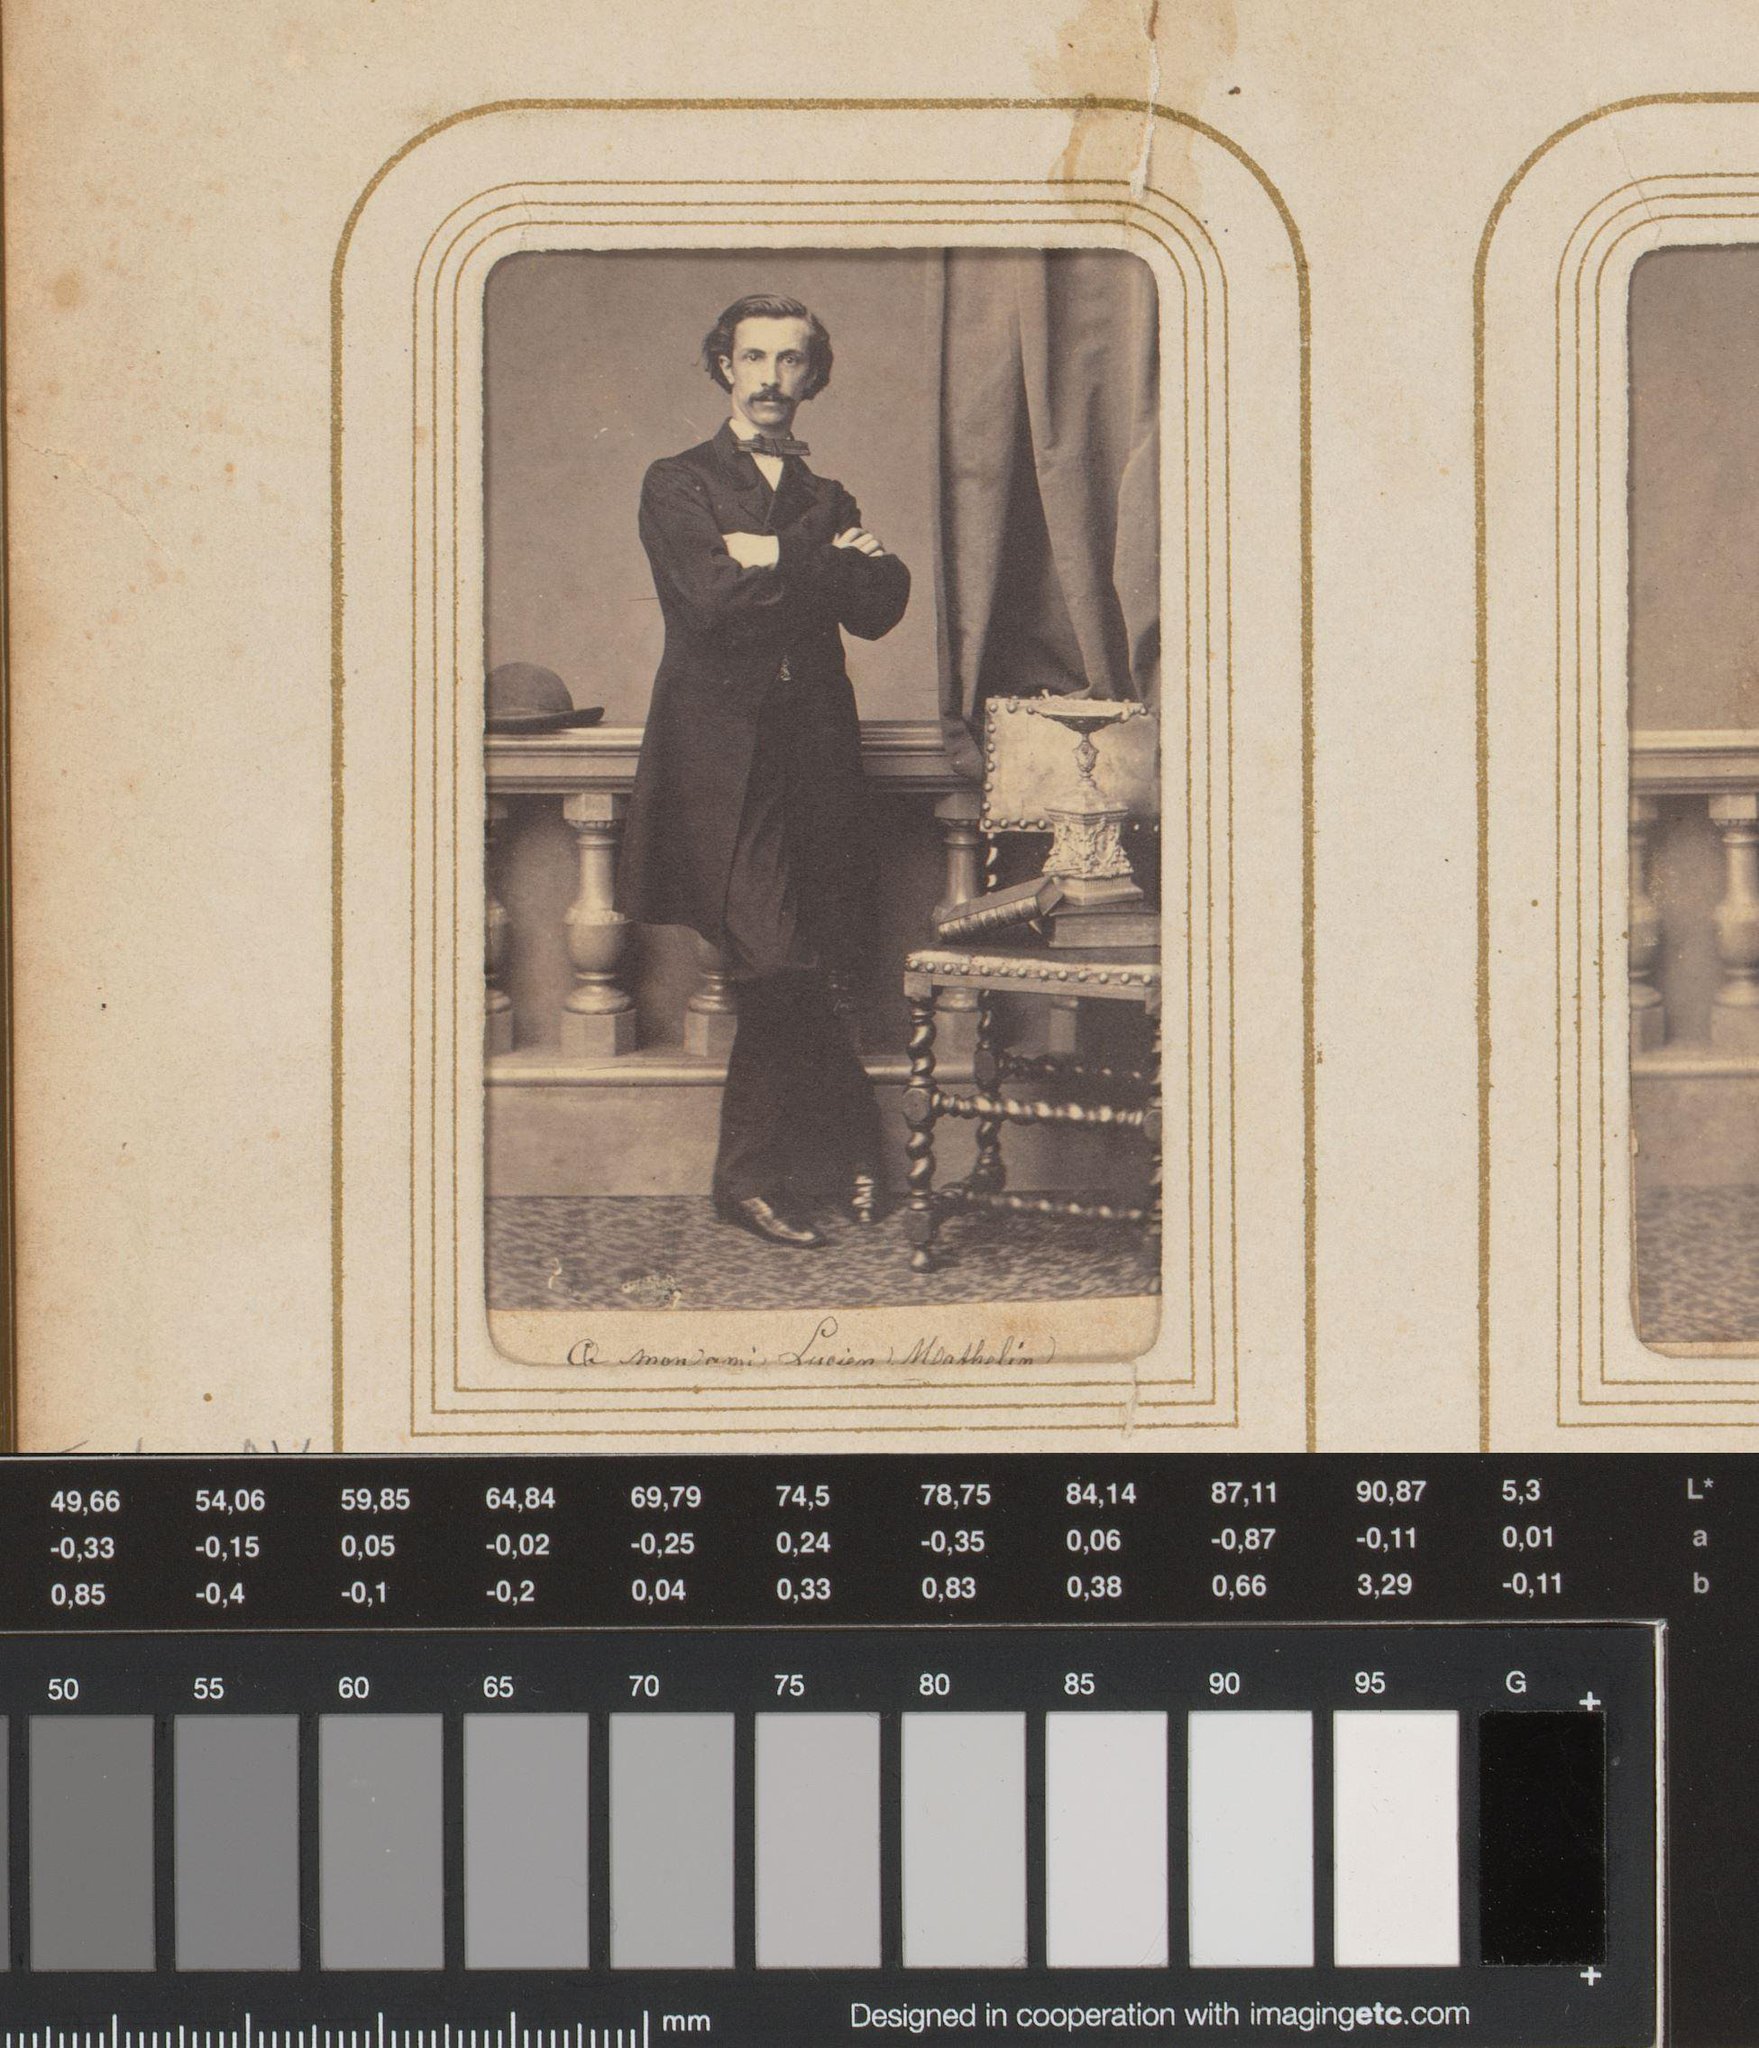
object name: carte de visite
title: Portret van Lambert Herman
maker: Anonymous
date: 1861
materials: cardboard, photographic support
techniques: albumen print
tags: liège, sculptor, portrait, self-portrait of sculptor, historical persons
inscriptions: annotation: ‘artiste sculpteur 1861’, annotation: ‘De mon ami Lucien Mathelin/ [...] Herman’, annotation: ‘Lambert Herman beeldhouwer’